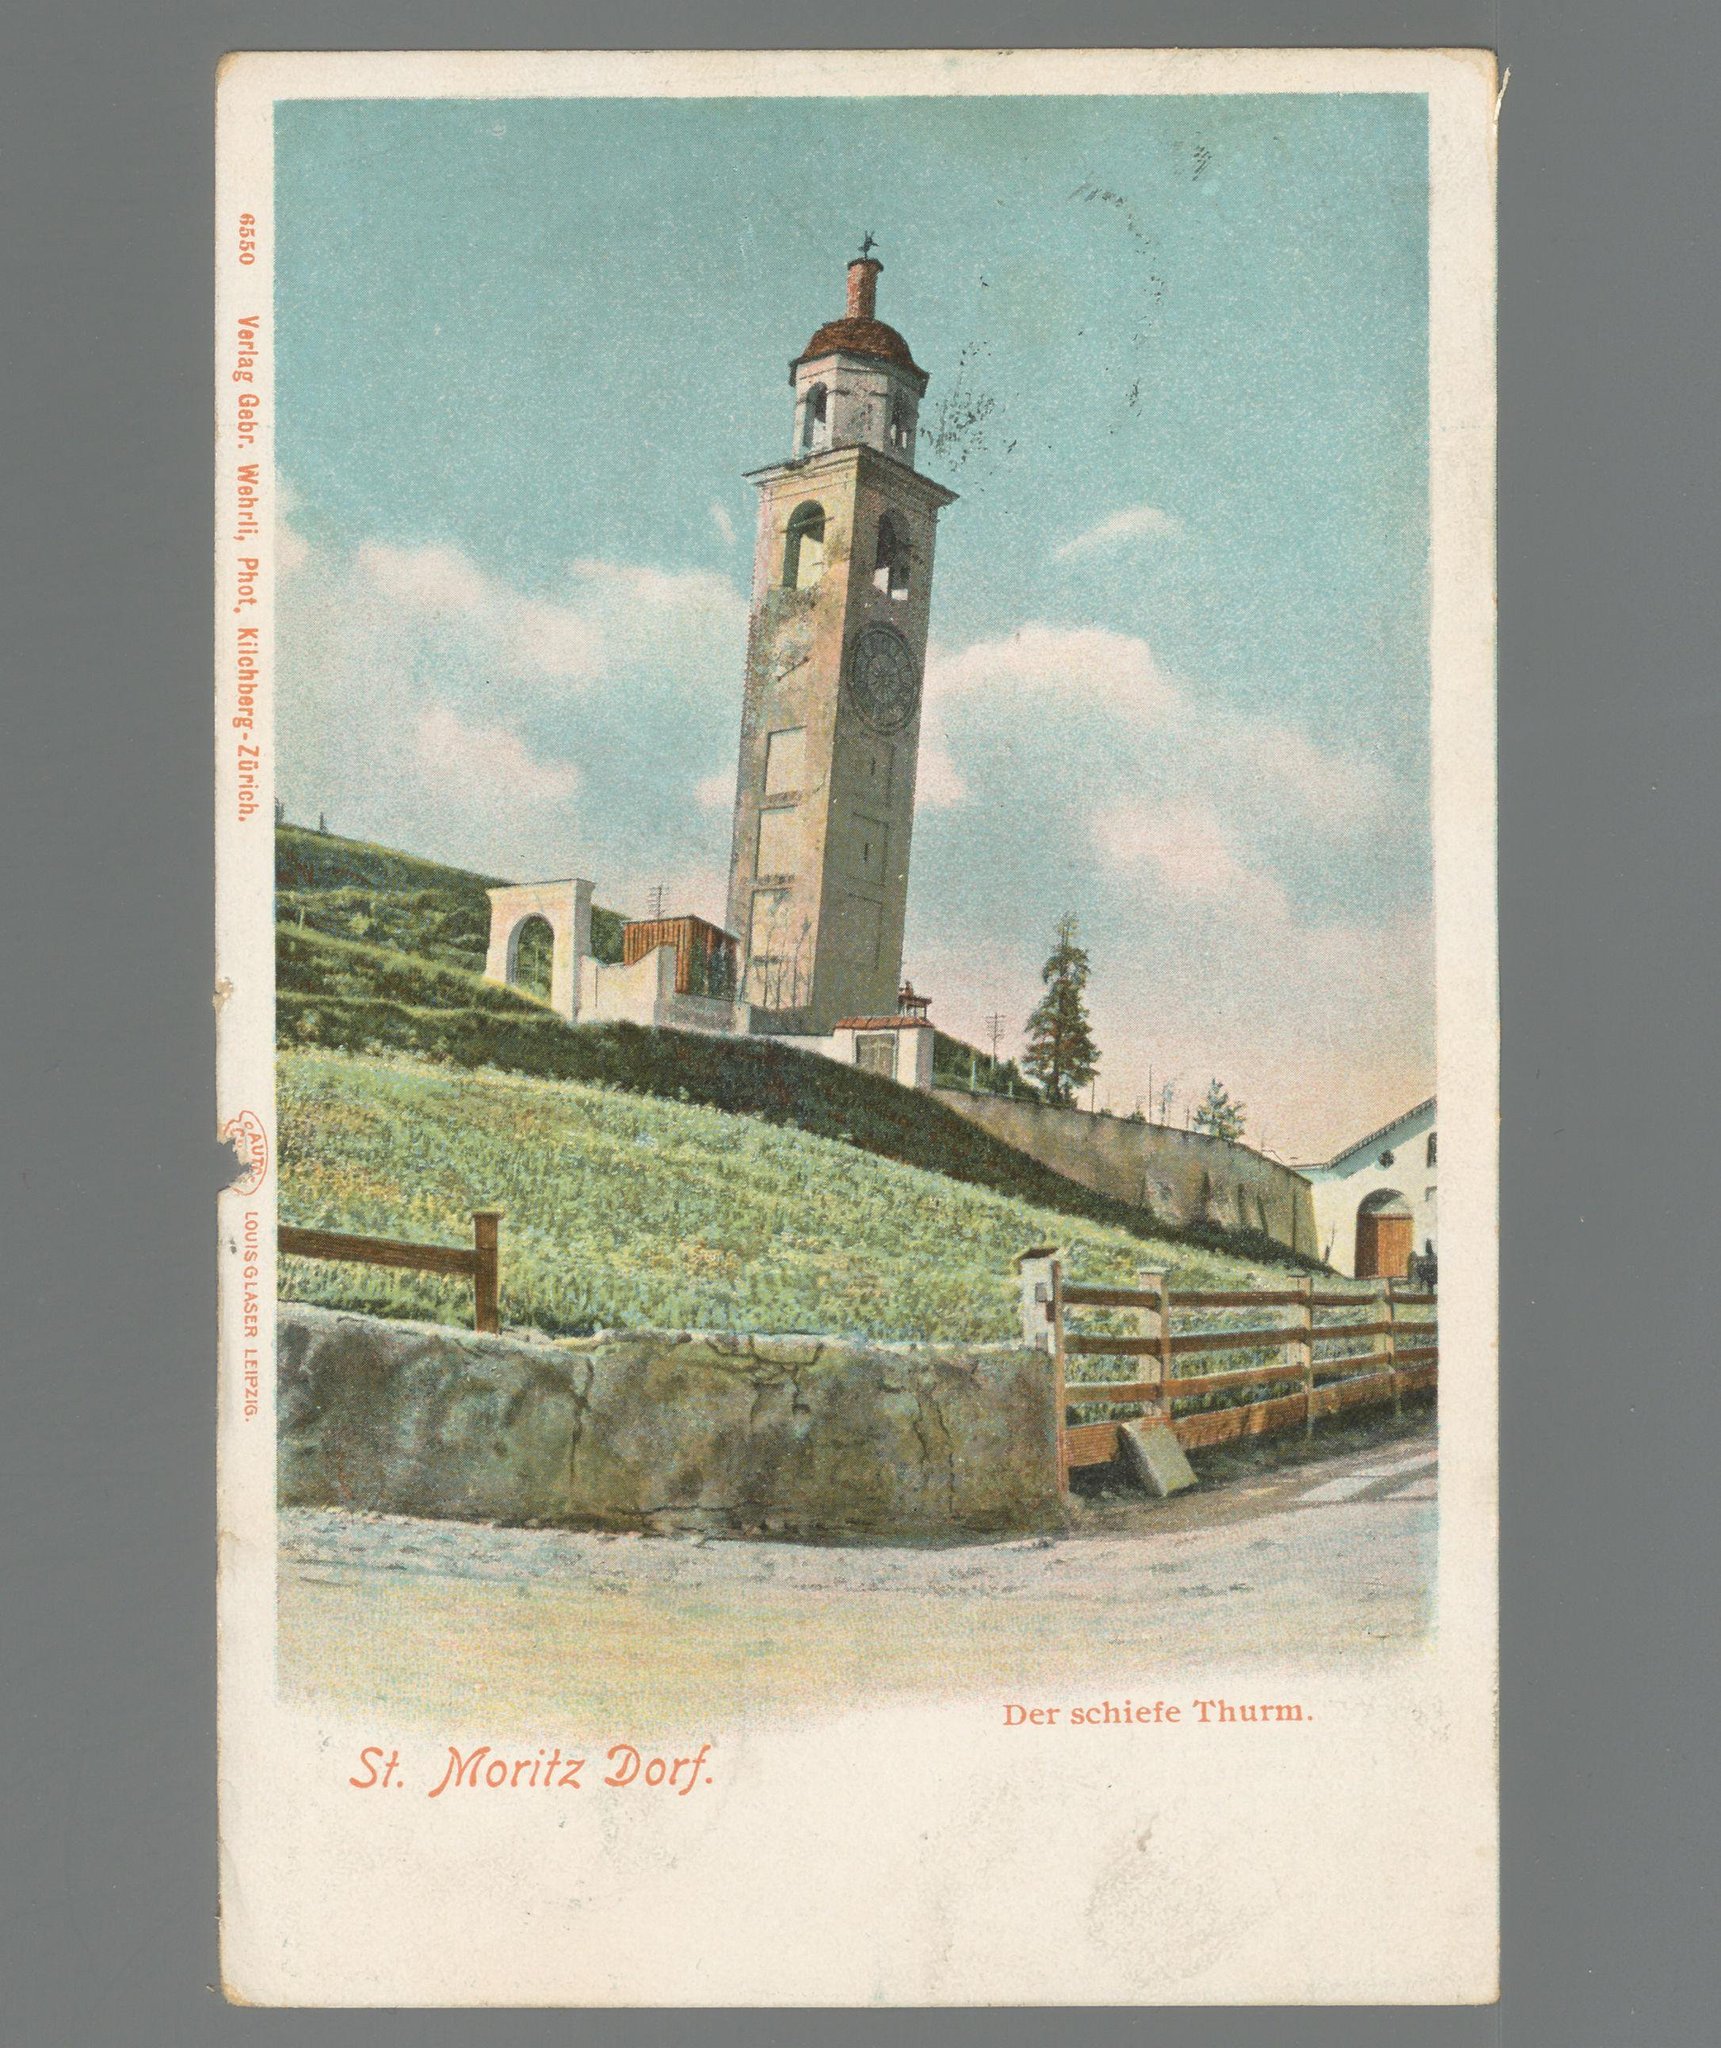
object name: photomechanical print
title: St. Moritz Dorf. Der schiefe Thurm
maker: louis glaser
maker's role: printer, publisher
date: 1897-1902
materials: cardboard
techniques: lithograph, writing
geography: sankt moritz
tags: tower, clock tower ~ monumental adornment, road, path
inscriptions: postage stamp